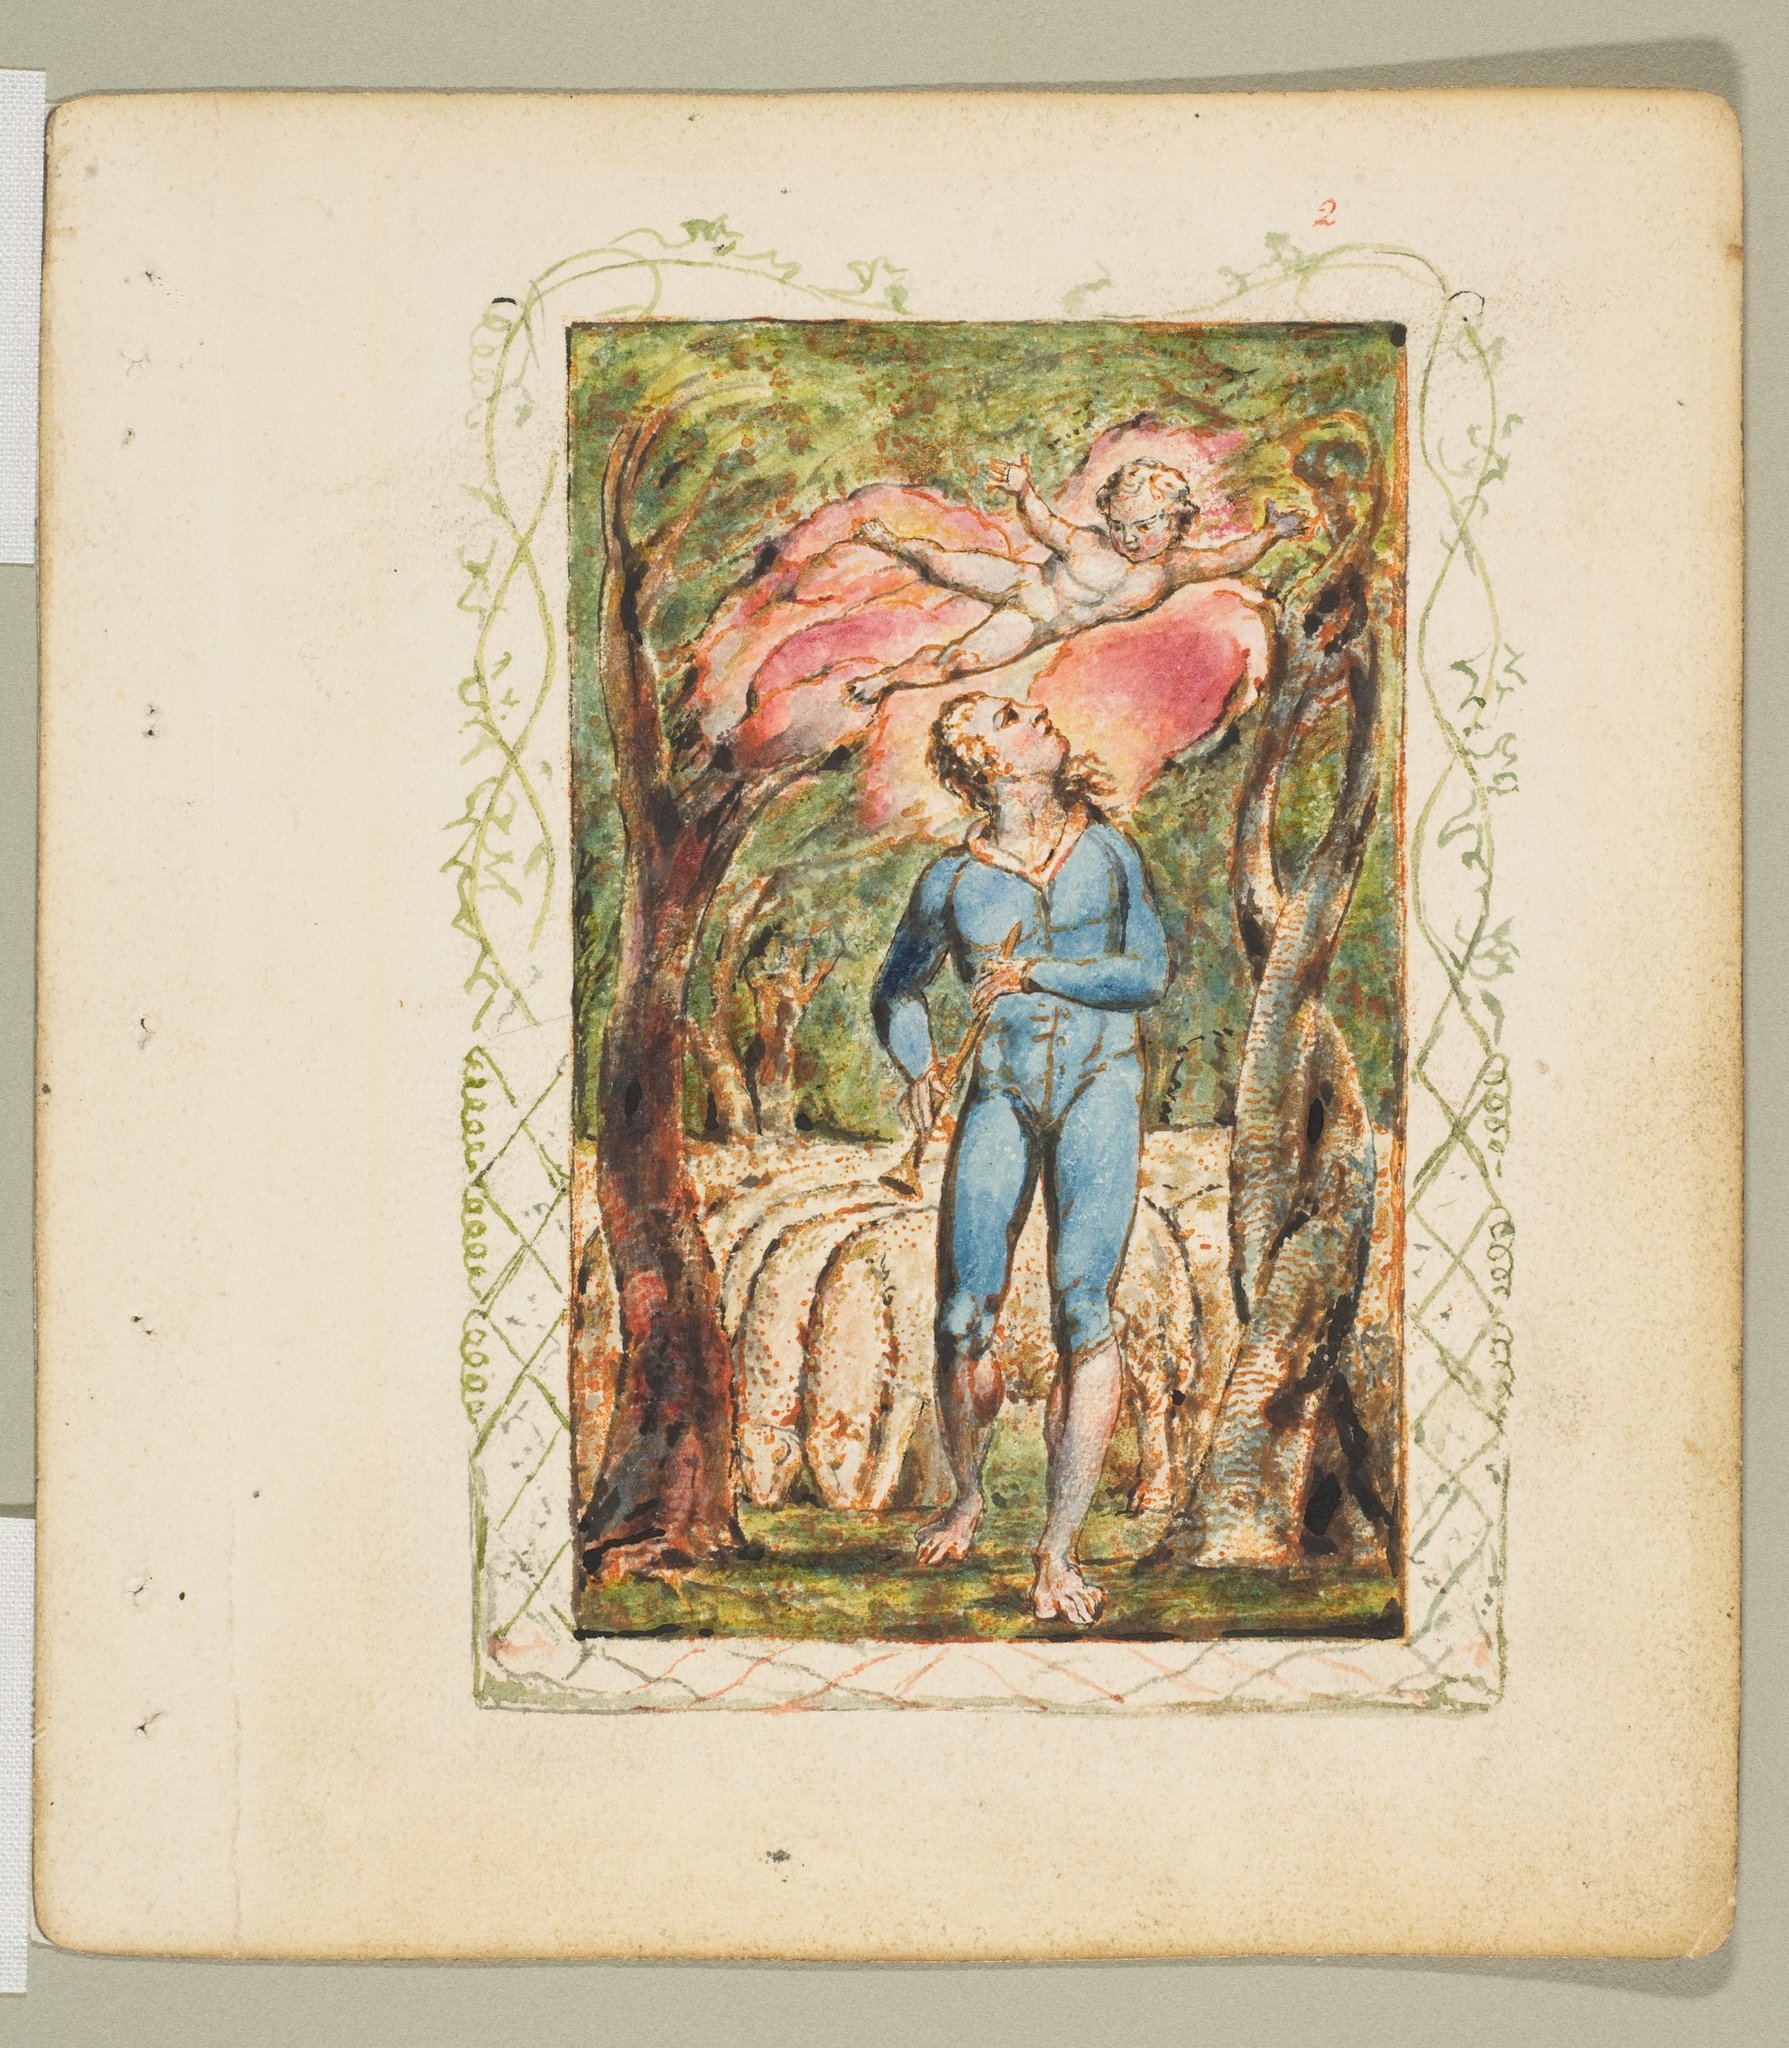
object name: print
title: Songs of Innocence: Frontispiece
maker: william blake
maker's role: artist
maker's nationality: british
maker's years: 1757-1827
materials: gold, ink, shell, watercolor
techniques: etching, hand coloring, printing, relief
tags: infants,men,musicians